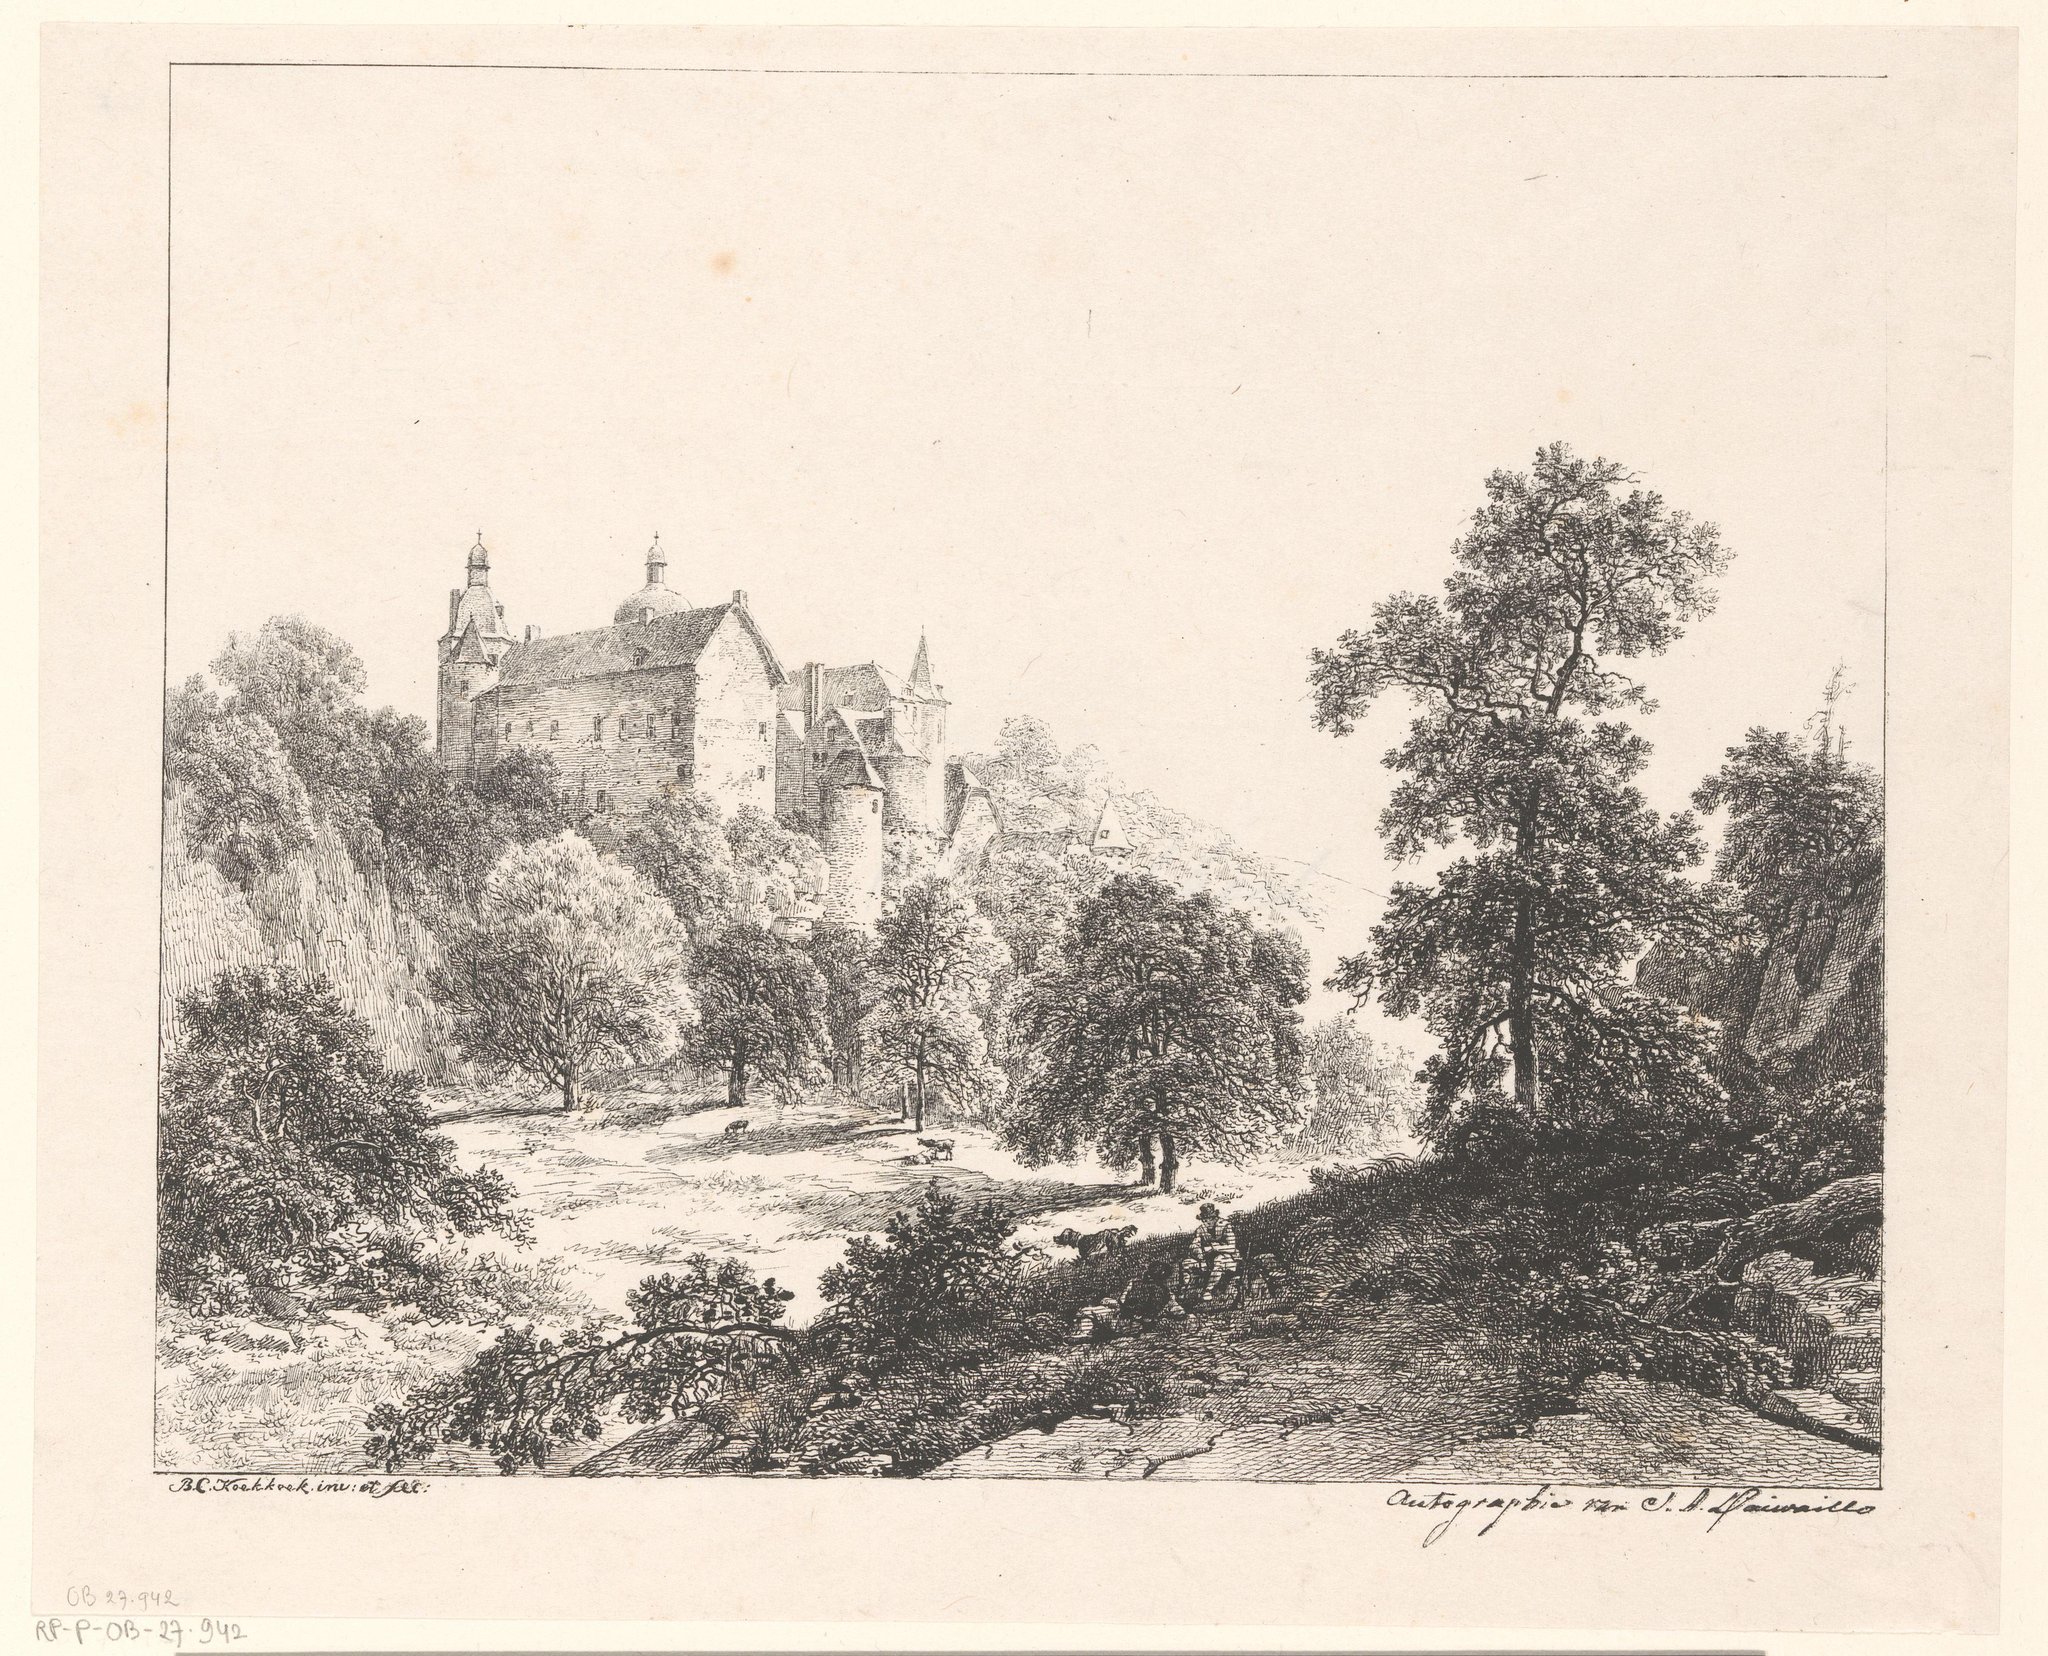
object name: print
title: Environs de Namur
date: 1820-1833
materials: paper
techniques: lithograph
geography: amsterdam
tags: landscape with tower or castle, landscapes in the temperate zone (+ landscape with figures, staffage)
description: Het woord 'autographie' rechtsonder op de prent verwijst, volgens C. J. de Bruyn Kops in het Bulletin van het Rijksmuseum, naar een techniek waarbij op glad papier werd getekend. Deze tekening werd vervolgens op de steen overgebracht. Tot slot werd hiermee gedrukt. Dit had het effect dat de afbeelding niet in spiegelbeeld werd afgedrukt en de tekenaar dus ook niet in spiegelbeeld hoefde te werken.